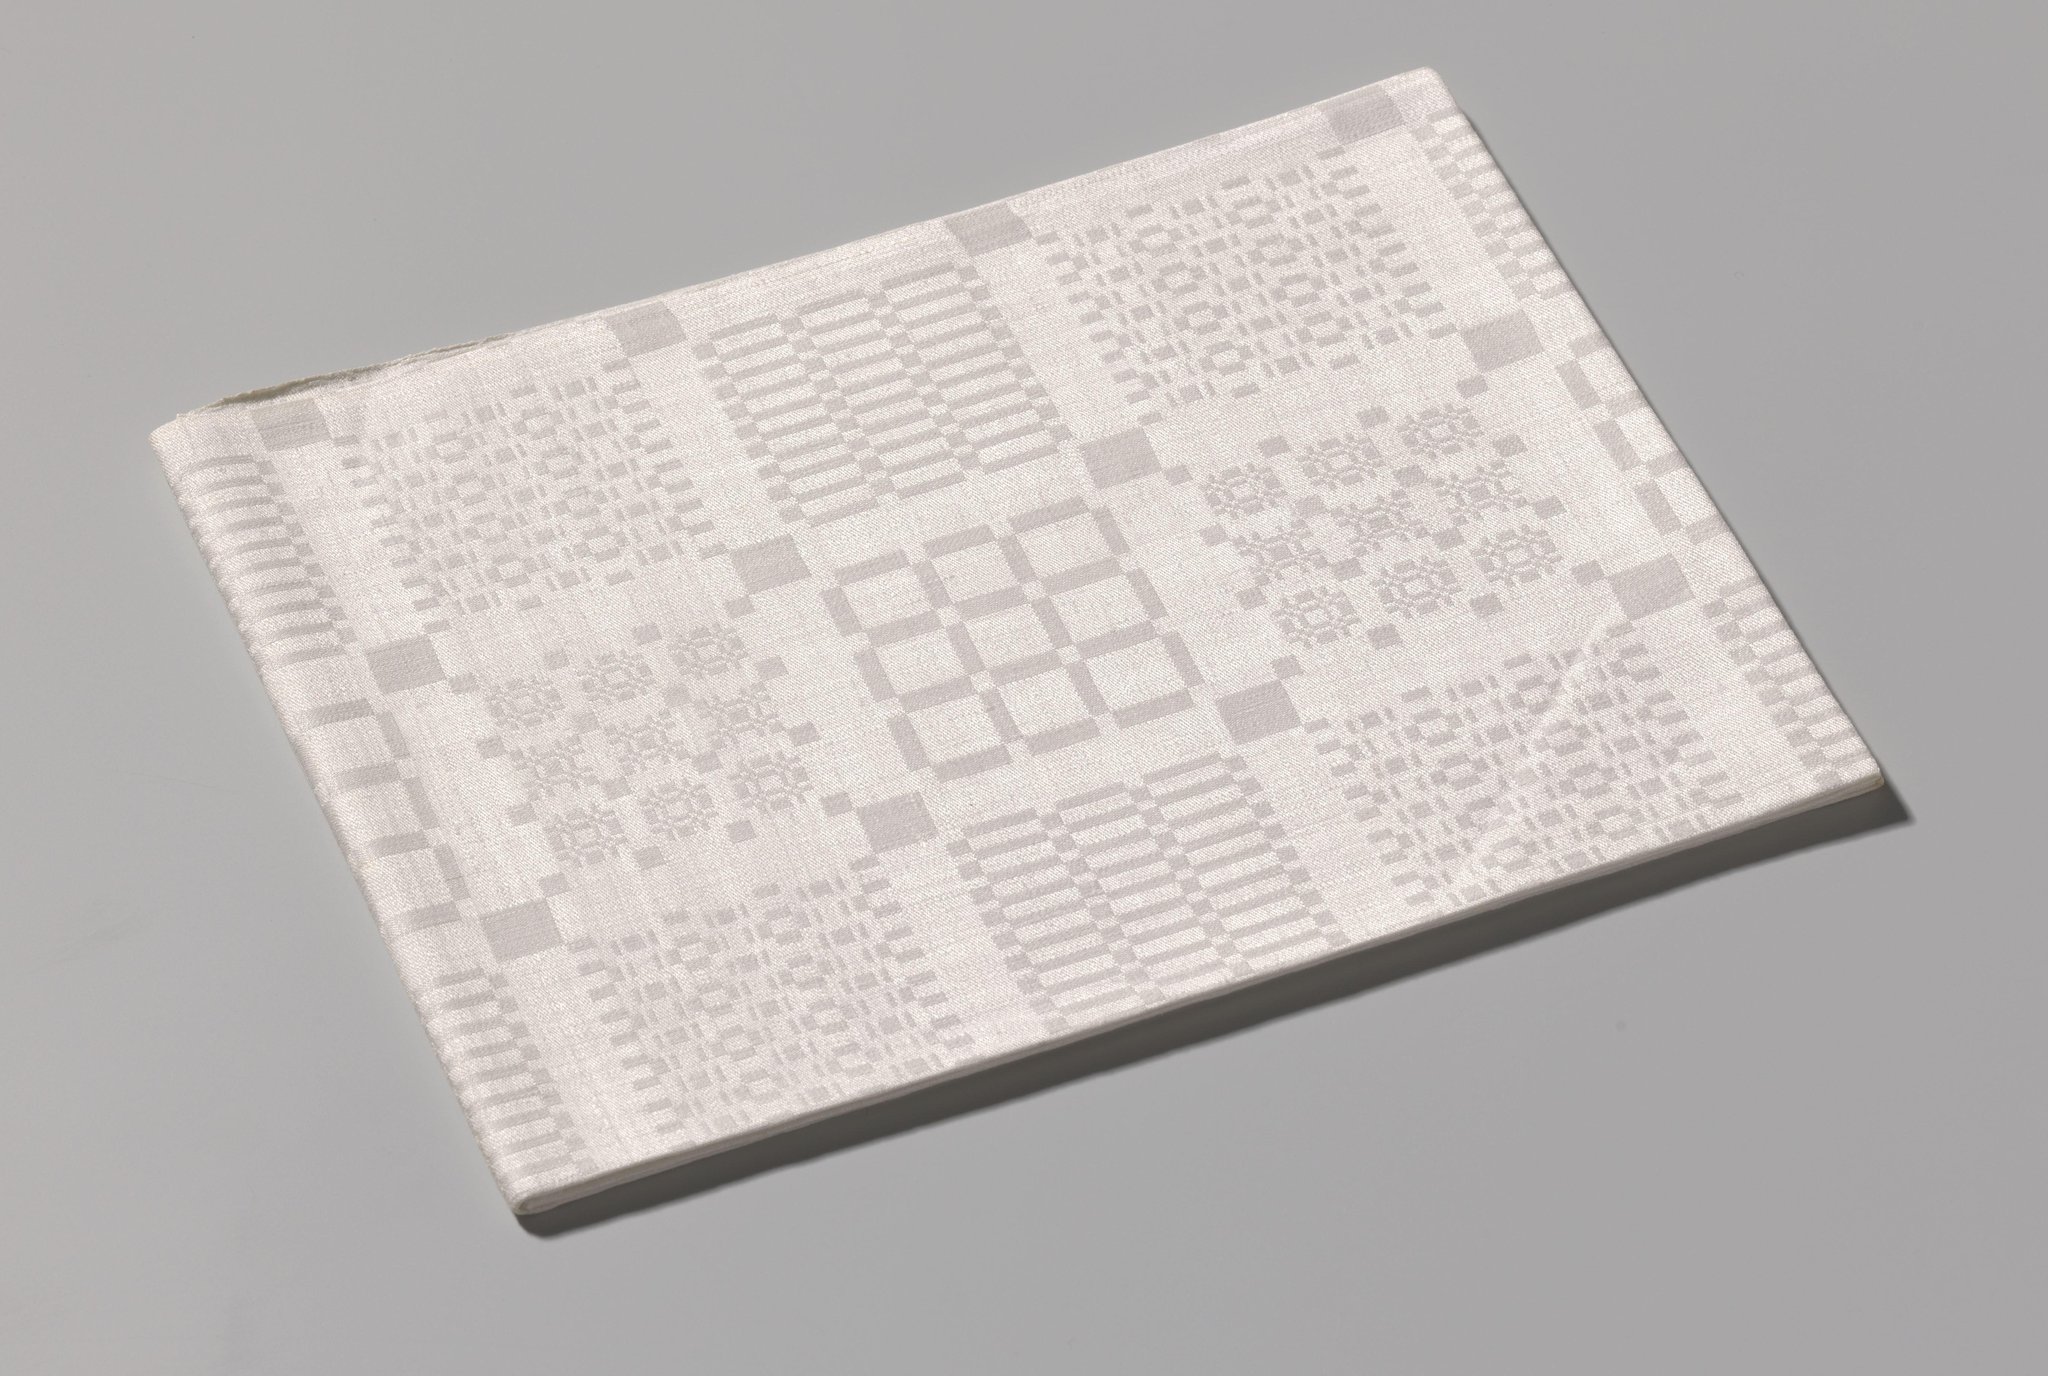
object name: napkin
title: Servet van linnen met pellenpatroon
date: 1737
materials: linen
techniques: peeled fabric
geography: northern netherlands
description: Wit linnen servet met pellenpatroon, genaamd "Oostindische caracters". Merk kroon WG 36 1737.